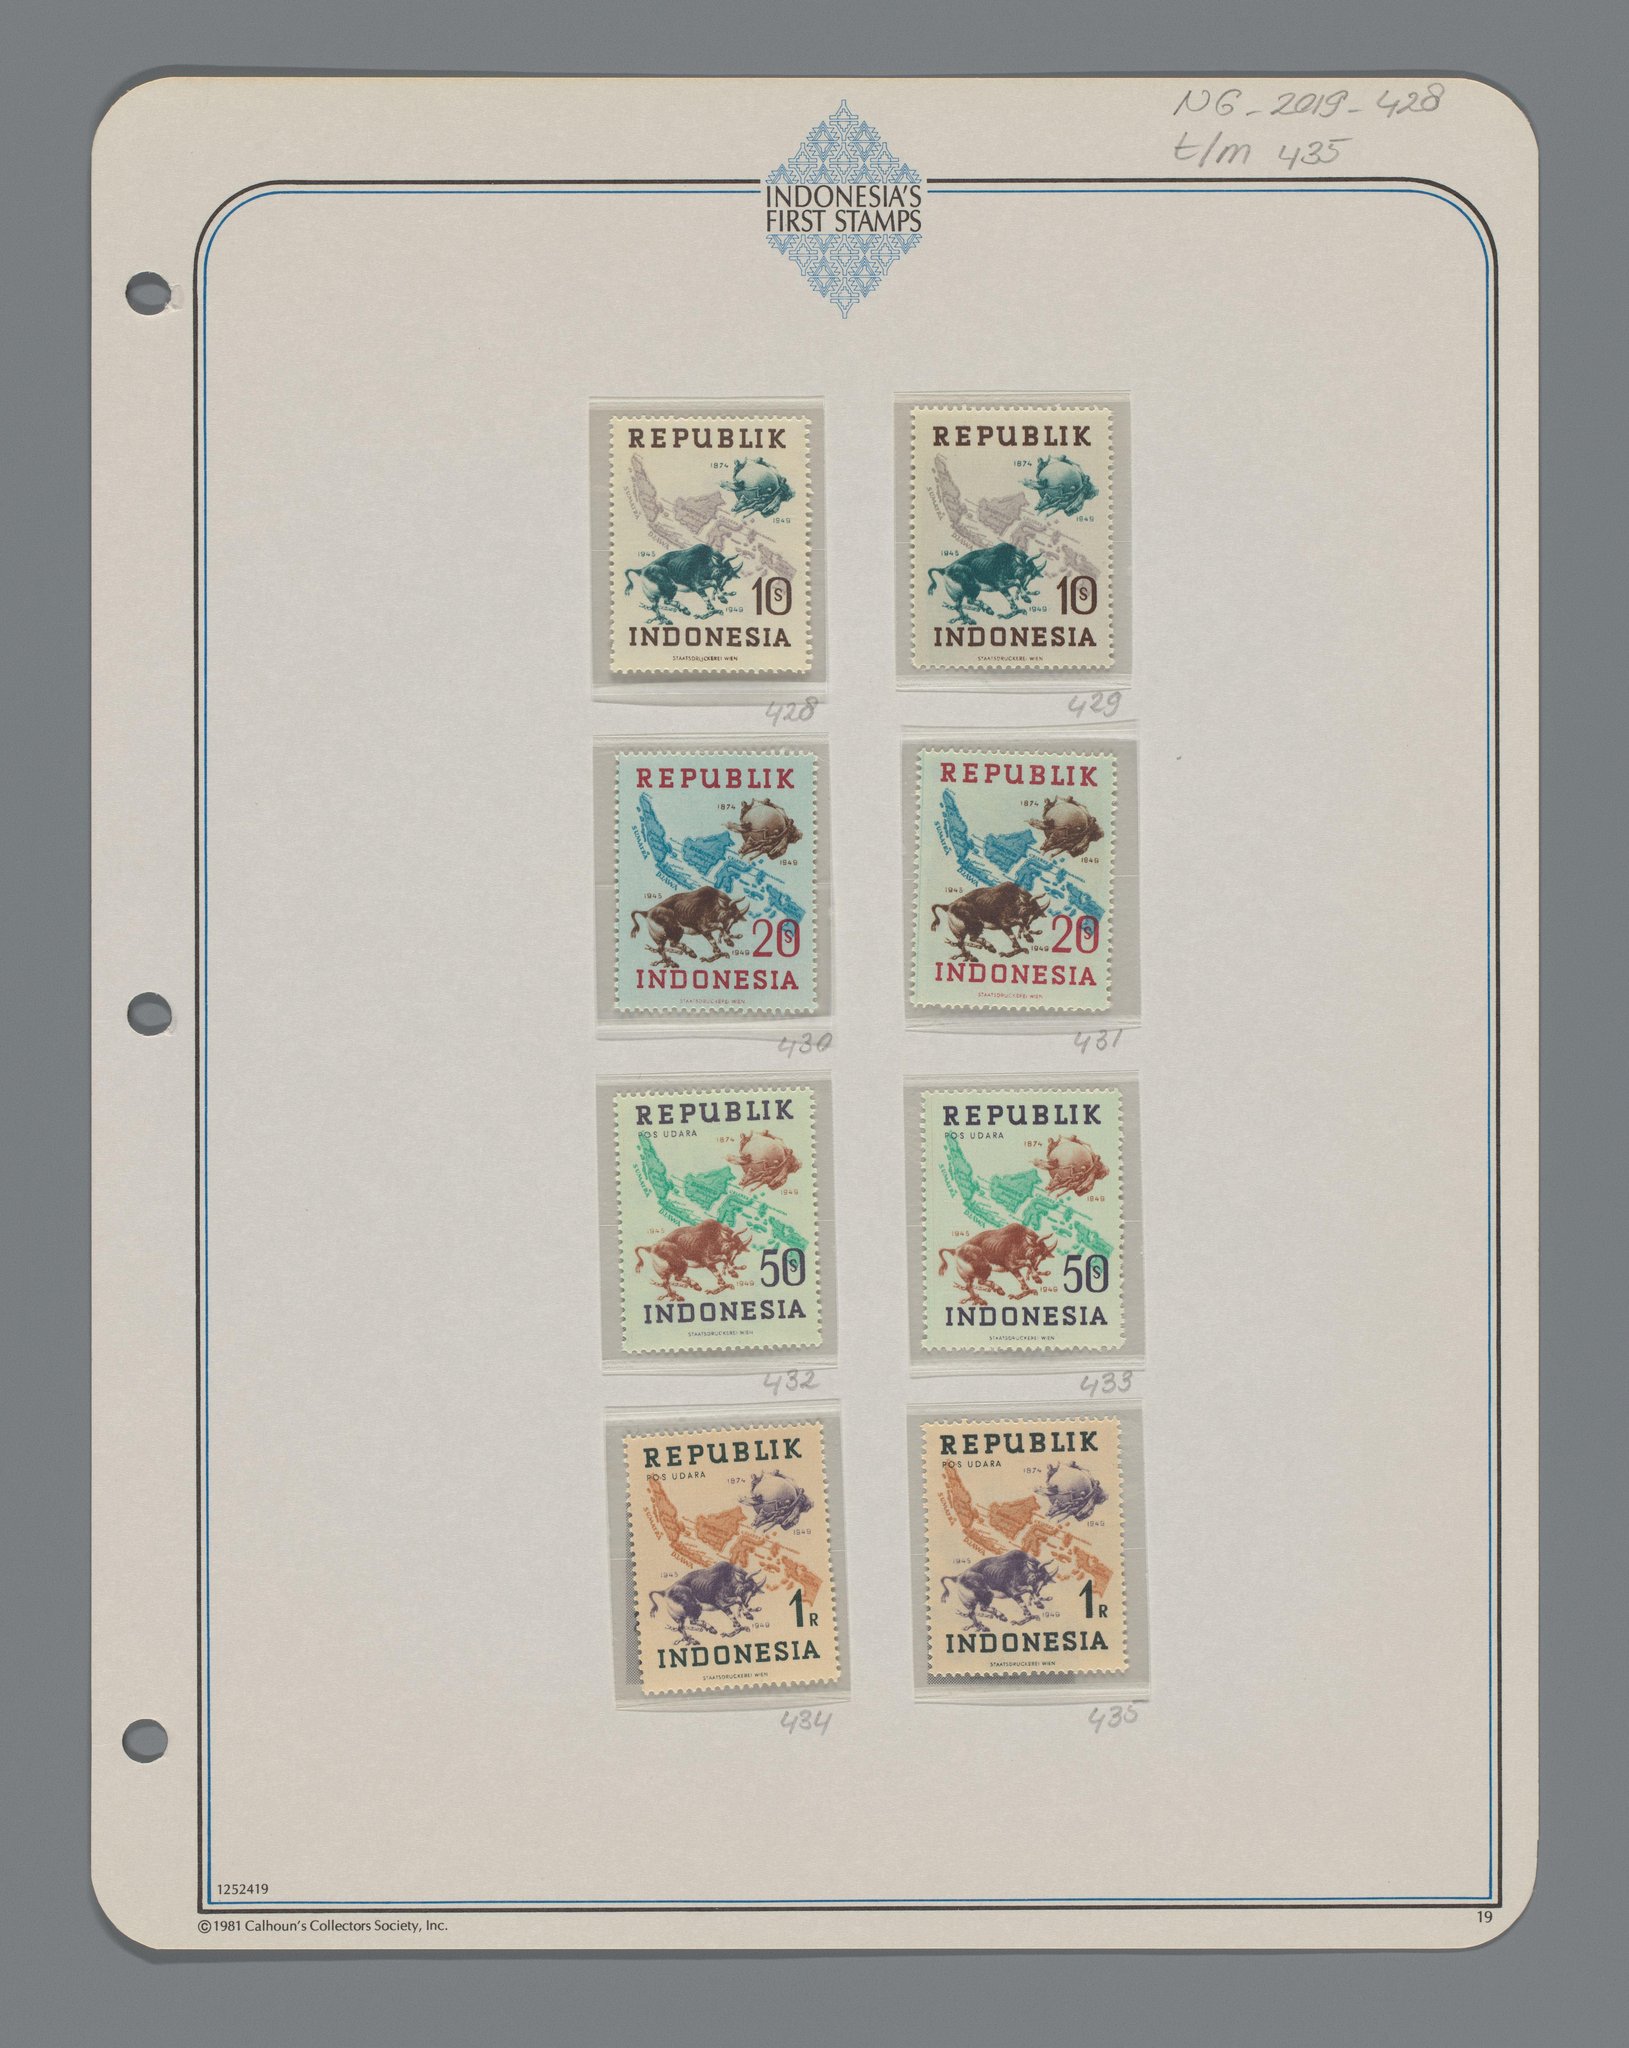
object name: postage stamp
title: Postzegel Republik Indonesia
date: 1949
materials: paper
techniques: photoaquatint, engraving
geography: philadelphia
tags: indonesia